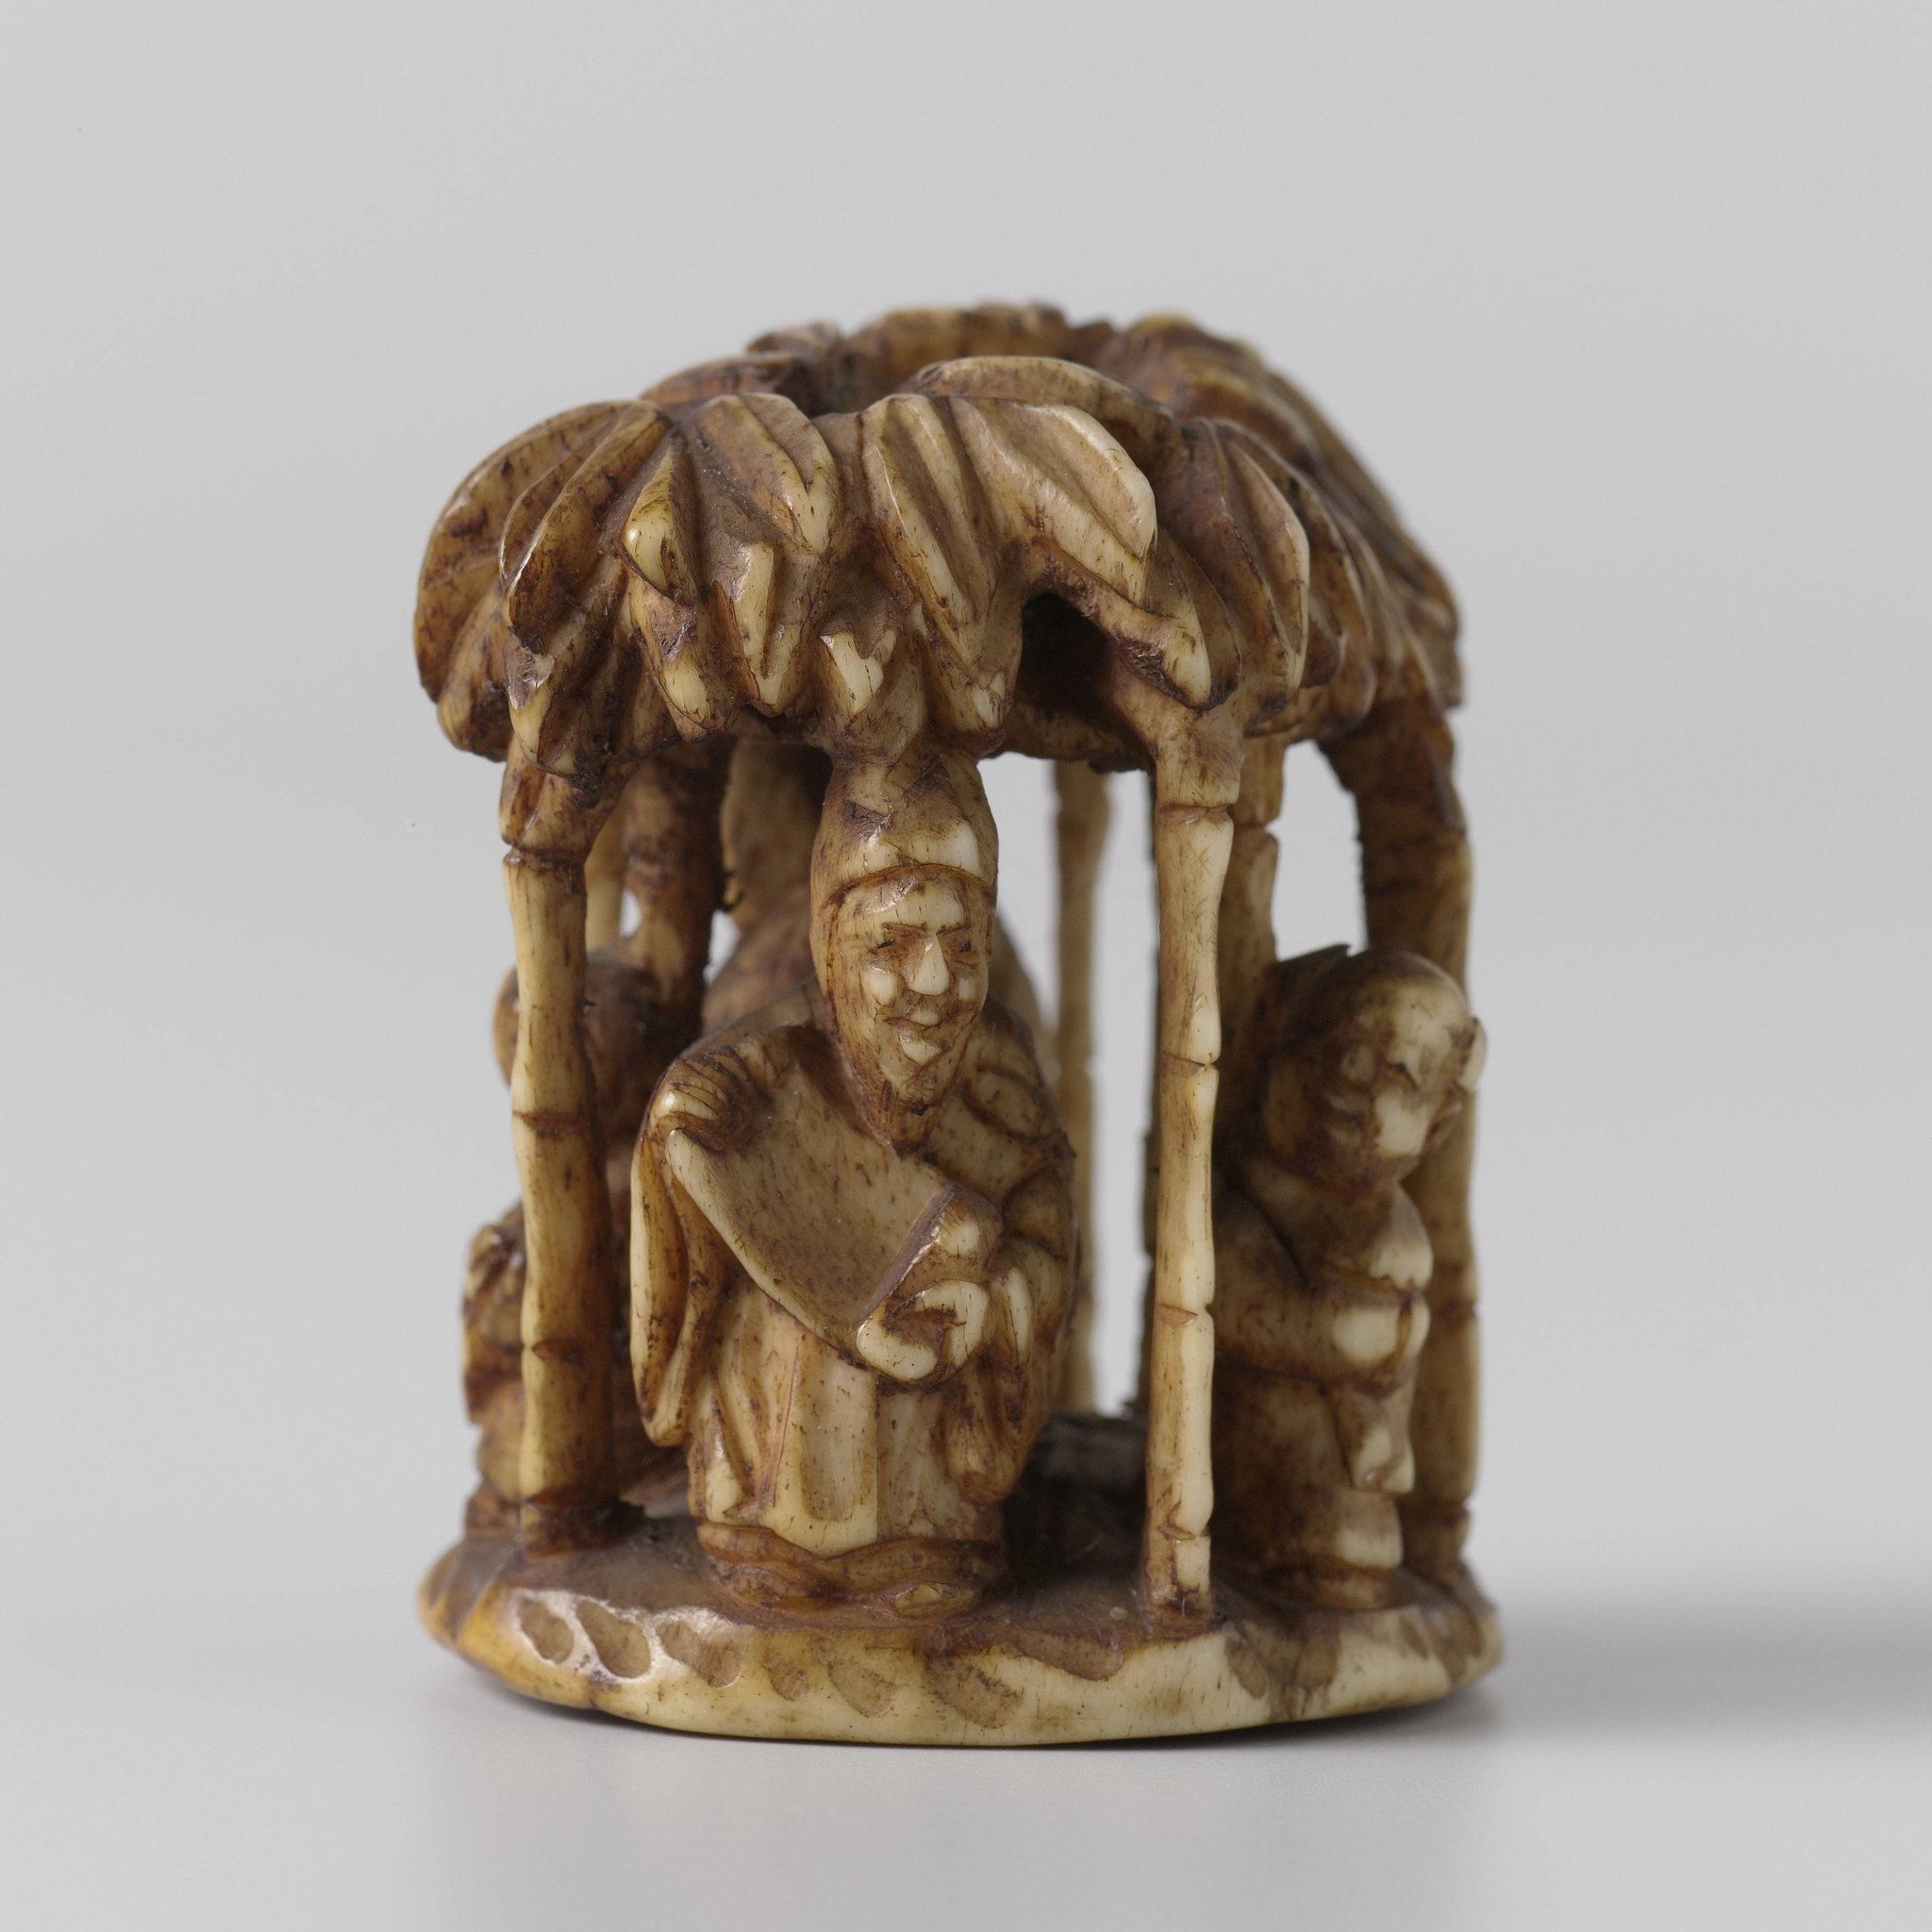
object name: netsuke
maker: Anonymous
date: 1700-1900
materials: ivory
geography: japan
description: Uitbeelding van vier figuren, wellicht tafereel in twee gedeeltes aan twee kanten van de netsuke. Inscriptie op de onderkant. Gat door het midden.